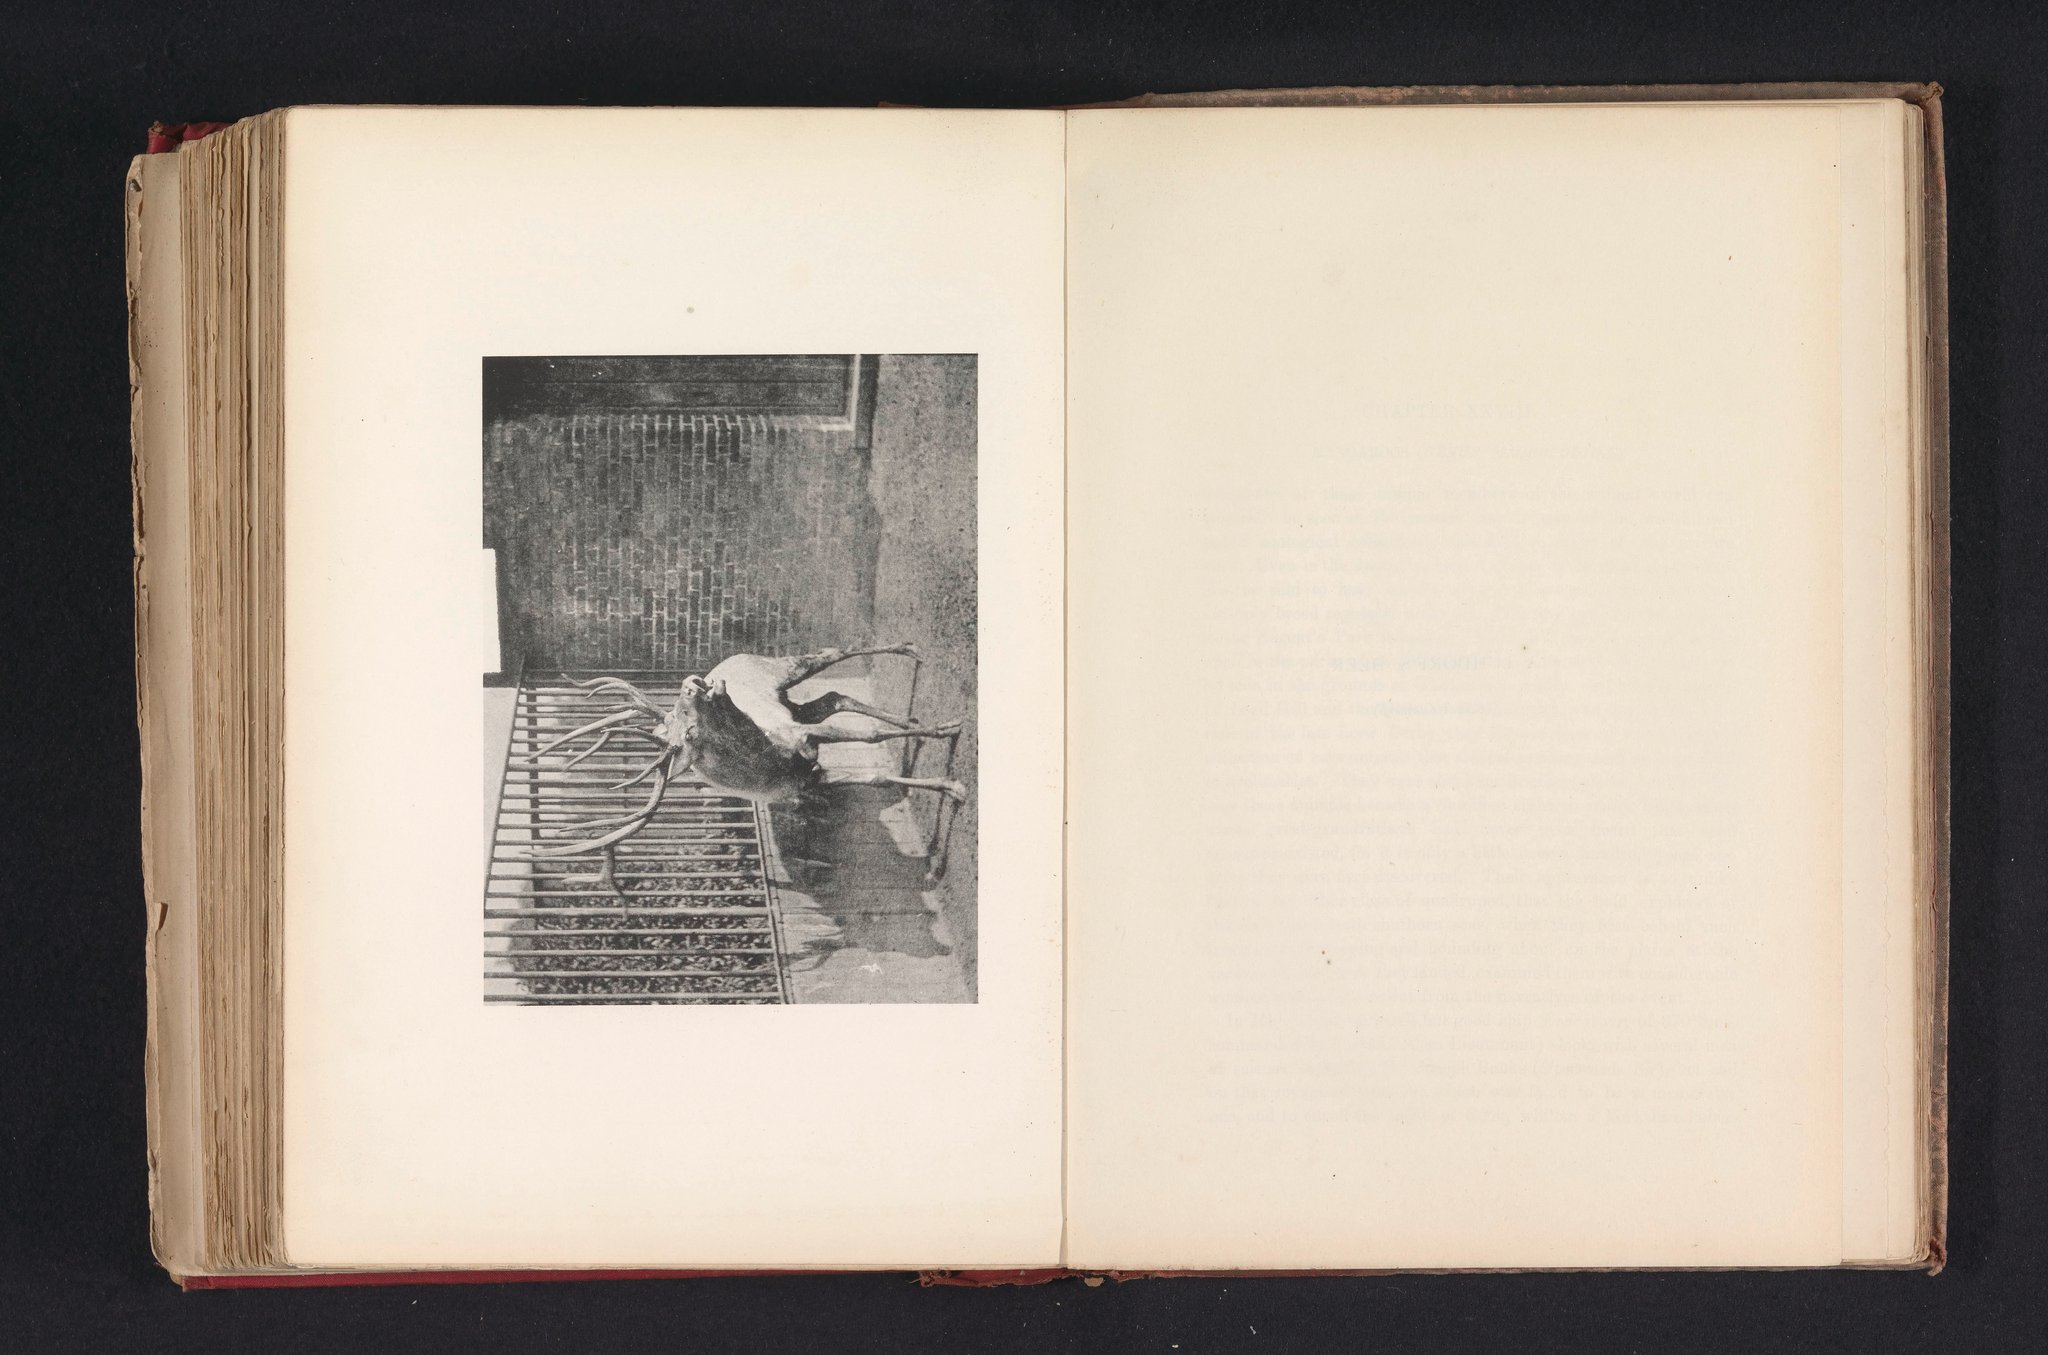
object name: photomechanical print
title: A Lühdorf's deer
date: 1876-1886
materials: paper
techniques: photograph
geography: paris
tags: hoofed animals: stag, zoological garden, zoo, seen as place where non-domestic animals are kept